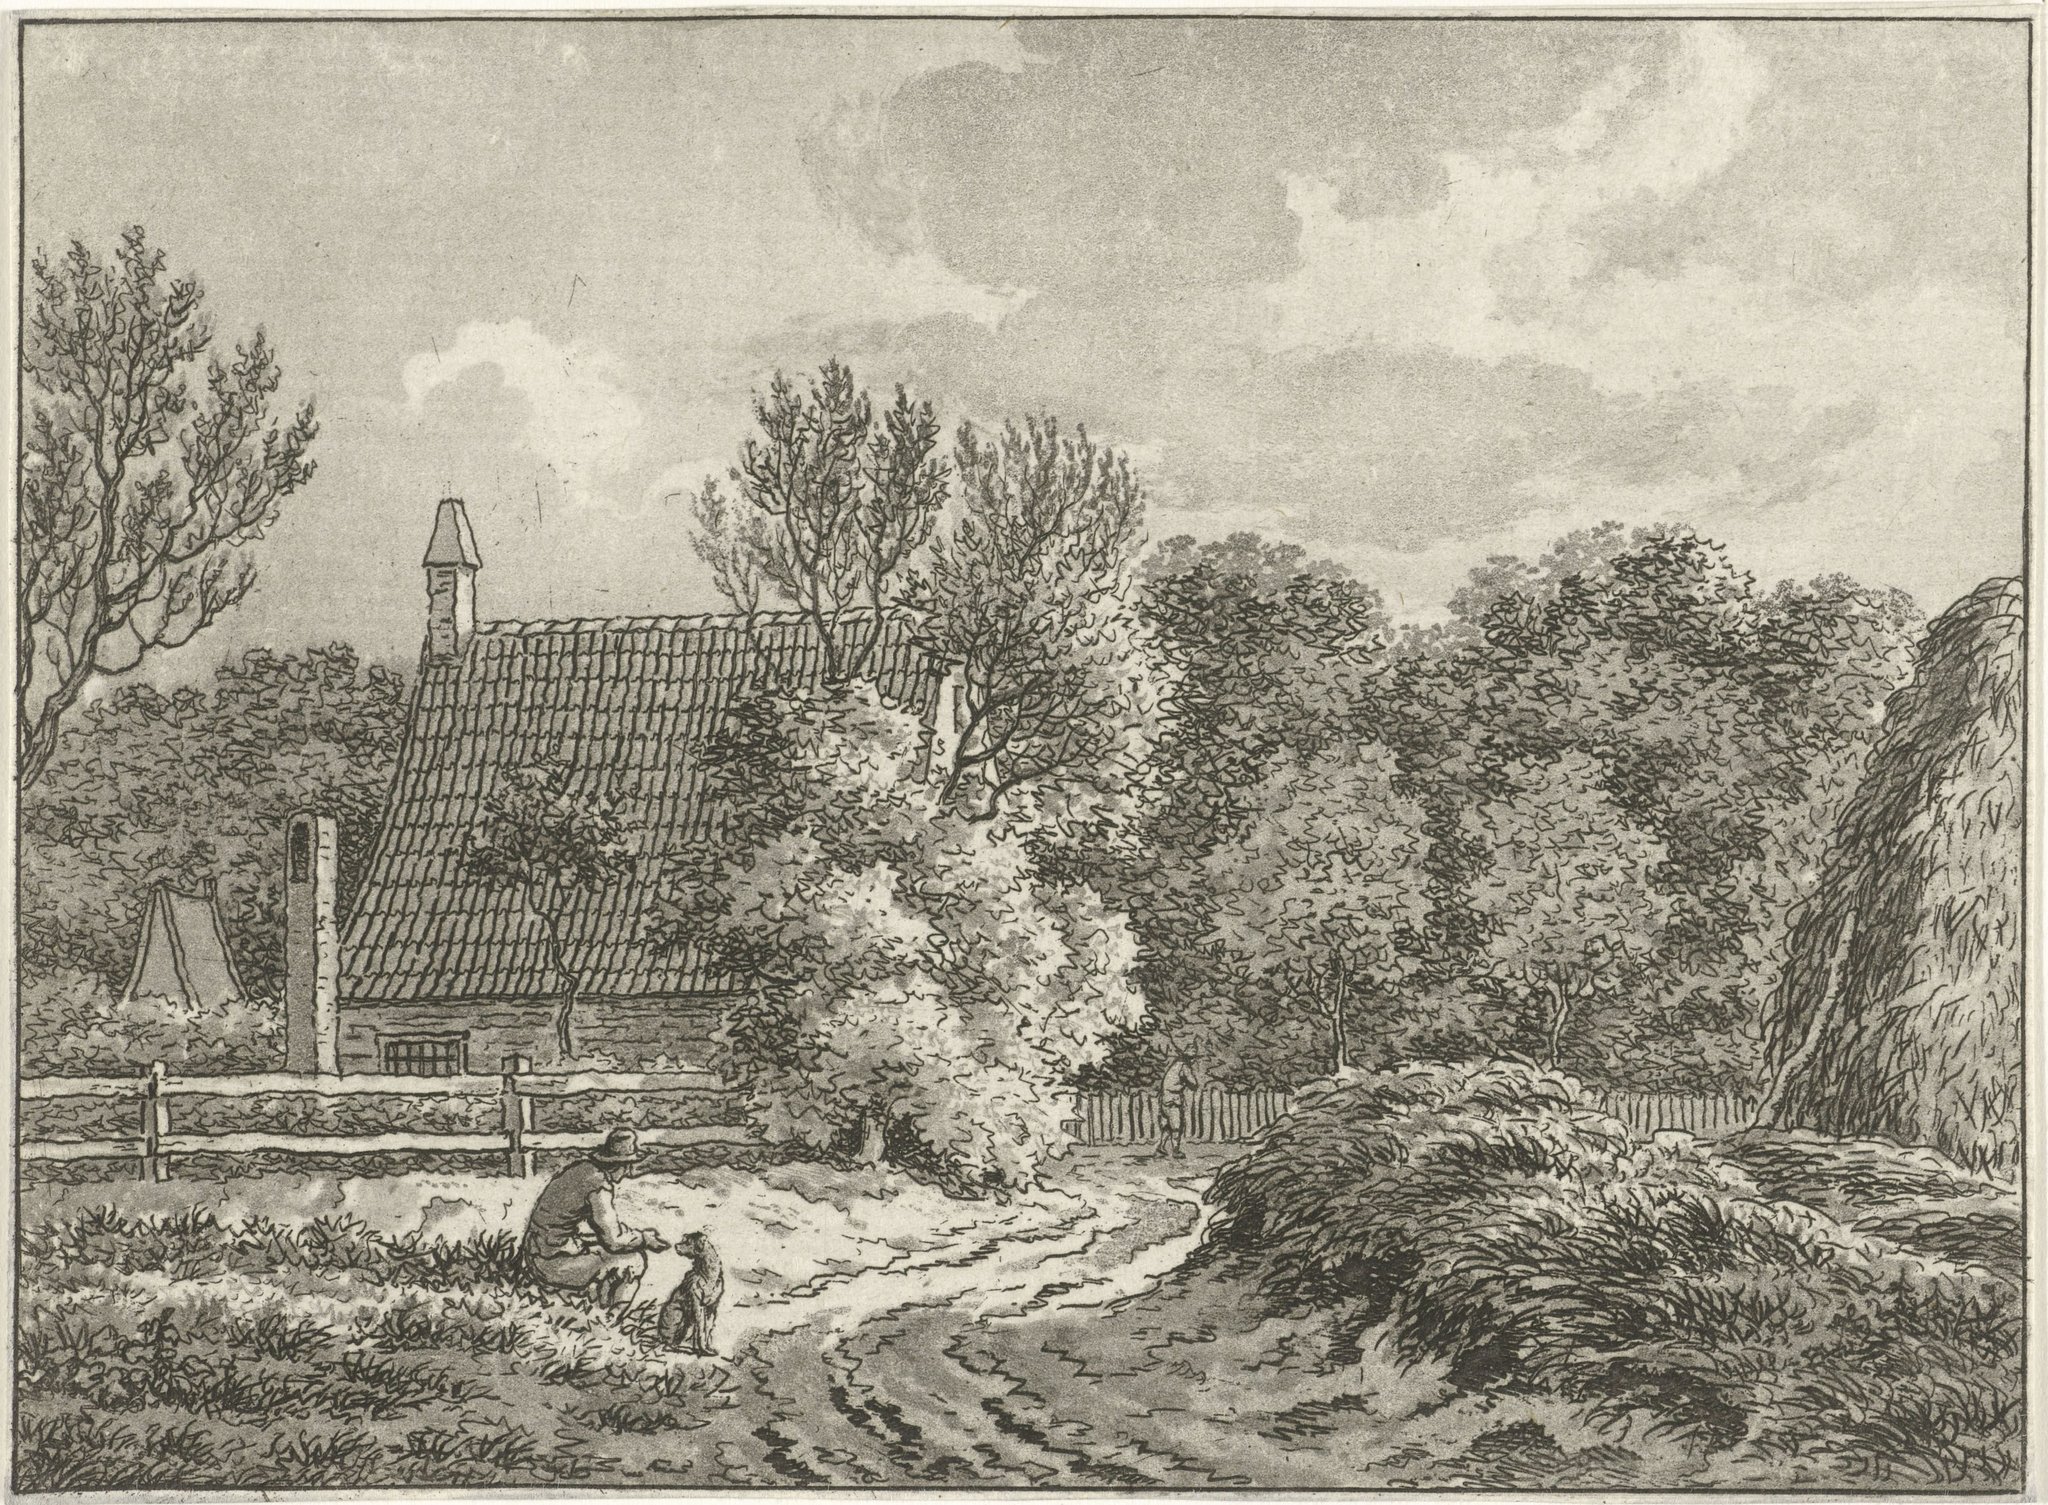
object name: print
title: Landschap bij Bloemendaal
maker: jan evert grave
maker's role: draughtsman, print maker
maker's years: 1759-1805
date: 1769-1805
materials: paper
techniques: aquatint, etching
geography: amsterdam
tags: farm or solitary house in landscape, public road (+ city(-scape) with figures, staffage)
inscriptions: caption: ‘Te Bloemendaal. J.E. De Grave’, collector's mark: Lugt 2228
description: Een landschap te Bloemendaal met enkele wandelaars op een weg. Op de voorgrond een zit een man naast de weg met zijn hond. Op de achtergrond een huis.